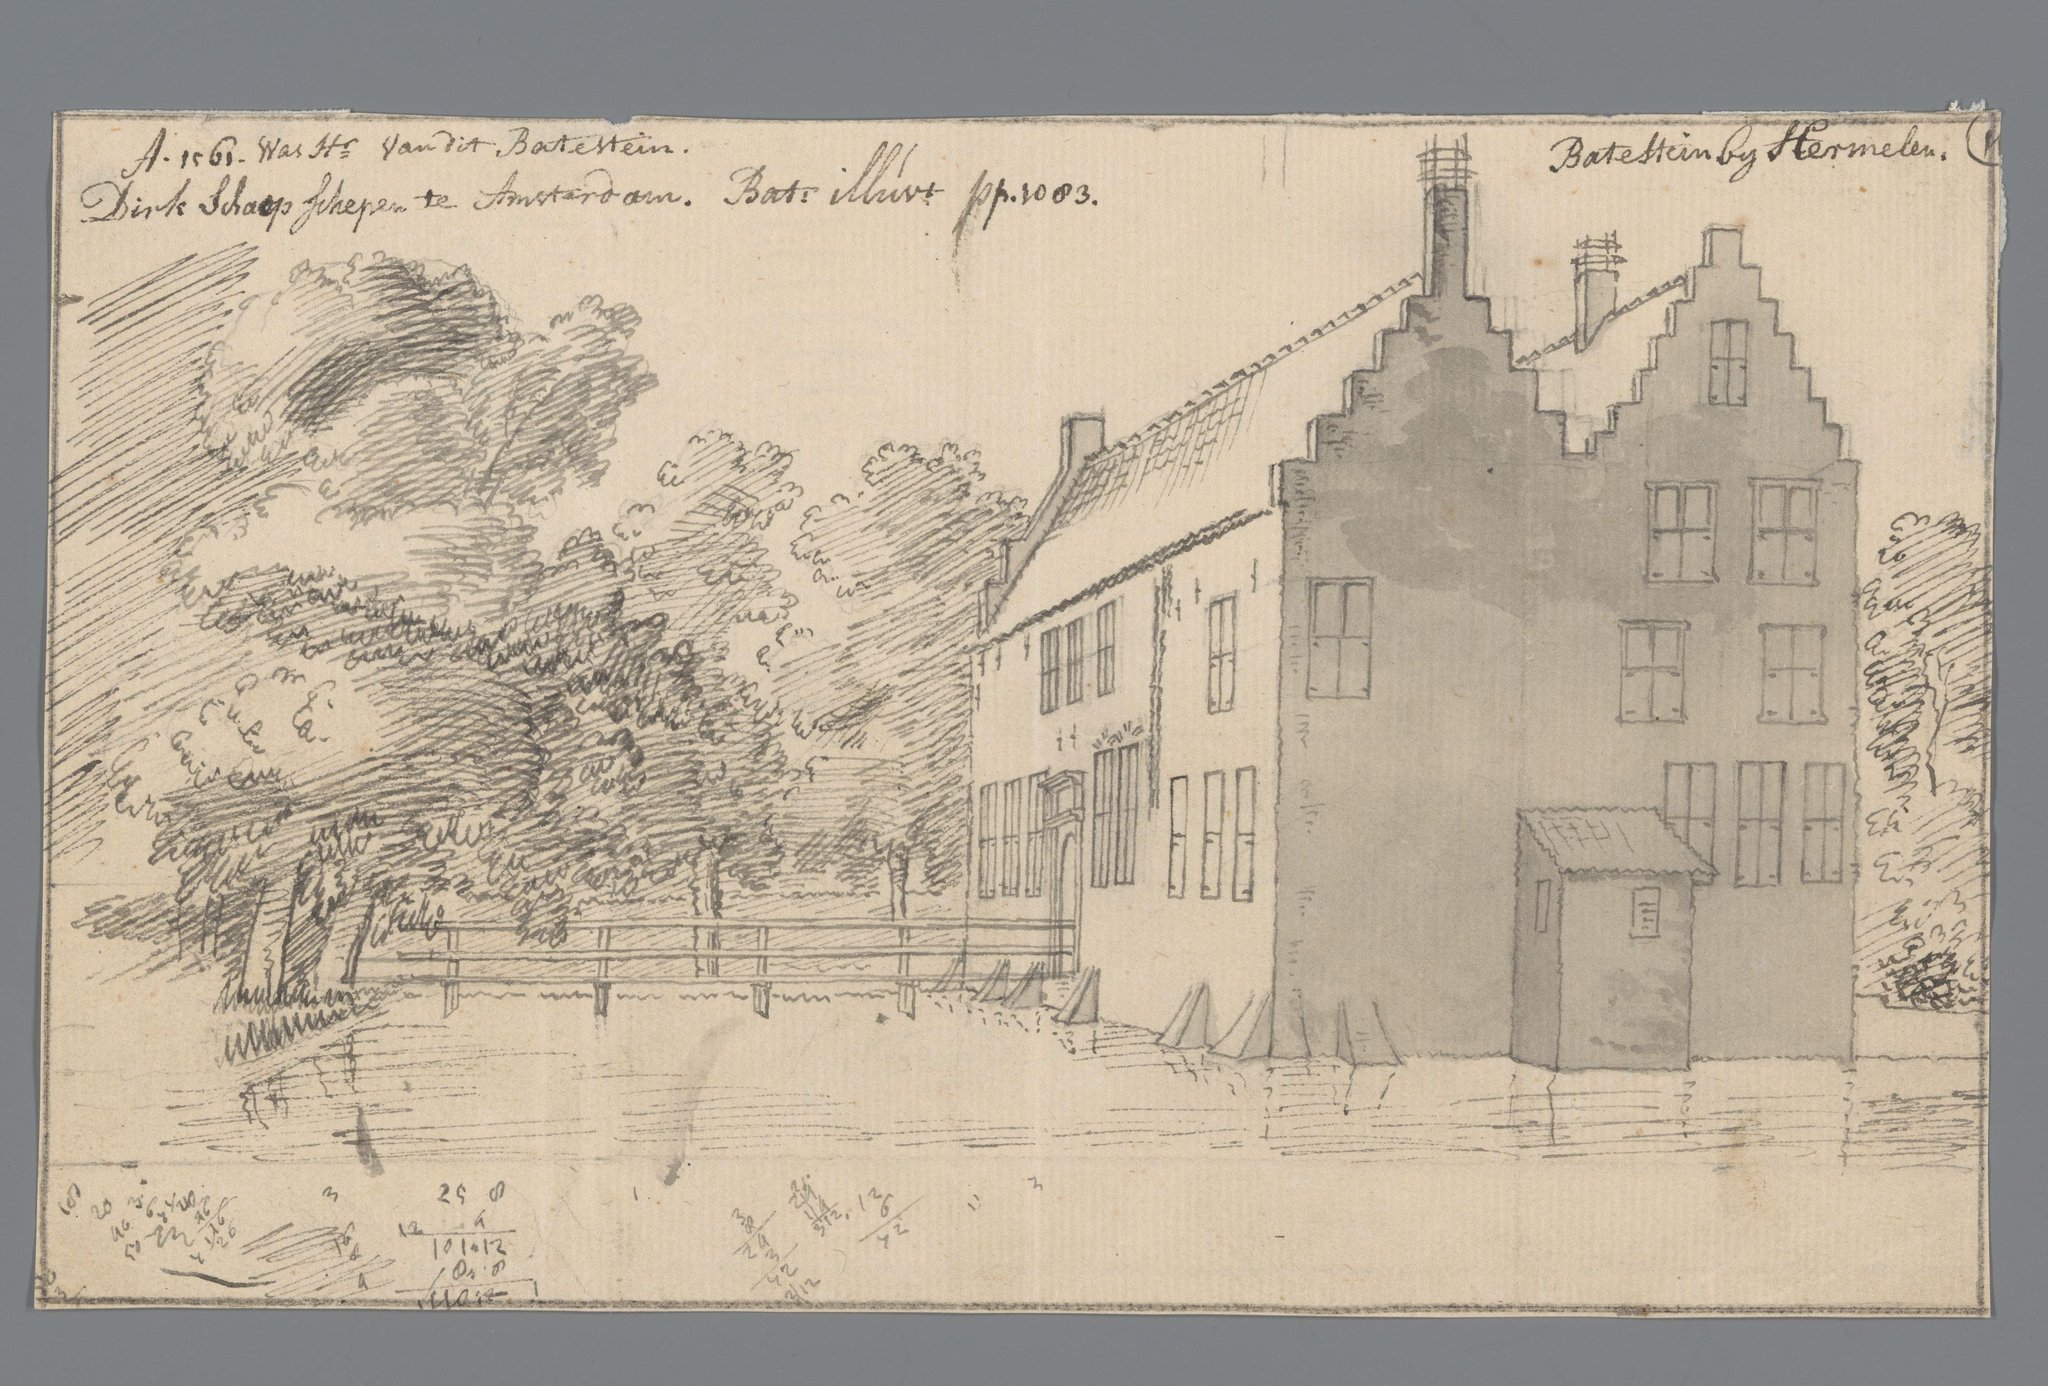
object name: drawing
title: Batestein by Hermelen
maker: jan caspar philips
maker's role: draughtsman, print maker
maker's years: 1700-1775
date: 1710-1775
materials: ink, paper, pencil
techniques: brush, drawing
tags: castle, landscape with tower or castle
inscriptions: collector's mark: Lugt 2228, annotation: ‘"A.1561. was hr. van dit Batestein Dirk Schaep schepen te Amsterdam. Bat illustr pp. 1083"’, annotation: ‘Enkele berekeningen.’